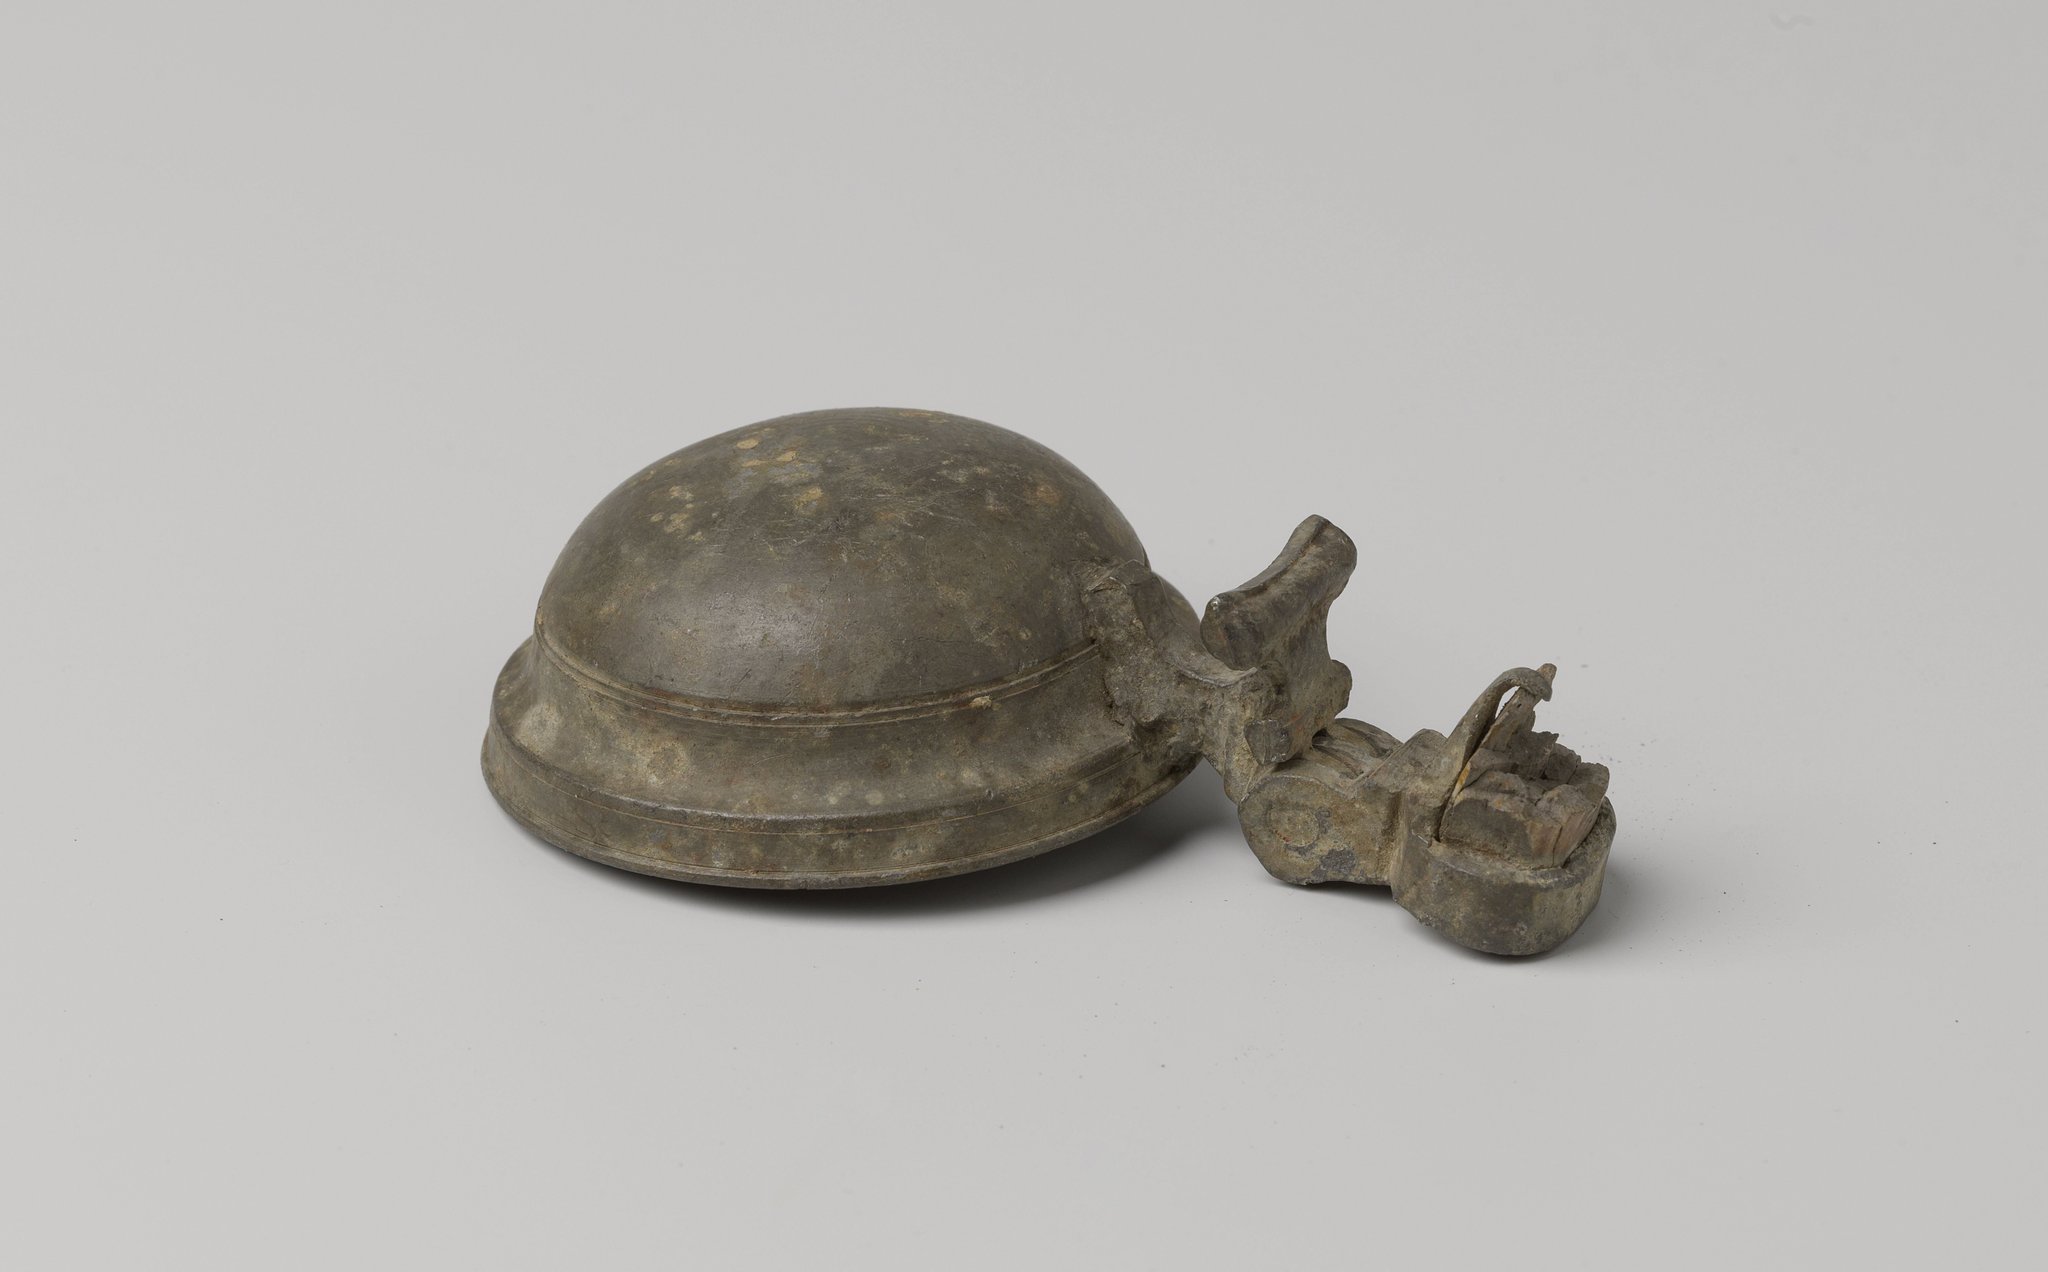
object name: jug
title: Deksel van tinnen flapkan of kruik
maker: Anonymous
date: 1590-1596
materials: tin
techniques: casting, striking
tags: willem barendsz., amsterdam, jacob van heemskerck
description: Deksel van tinnen flapkan of kruik. Het stuk dat aan oor bevestigd hoort te zijn is afgebroken met nog stukje van stenen kruik erin.